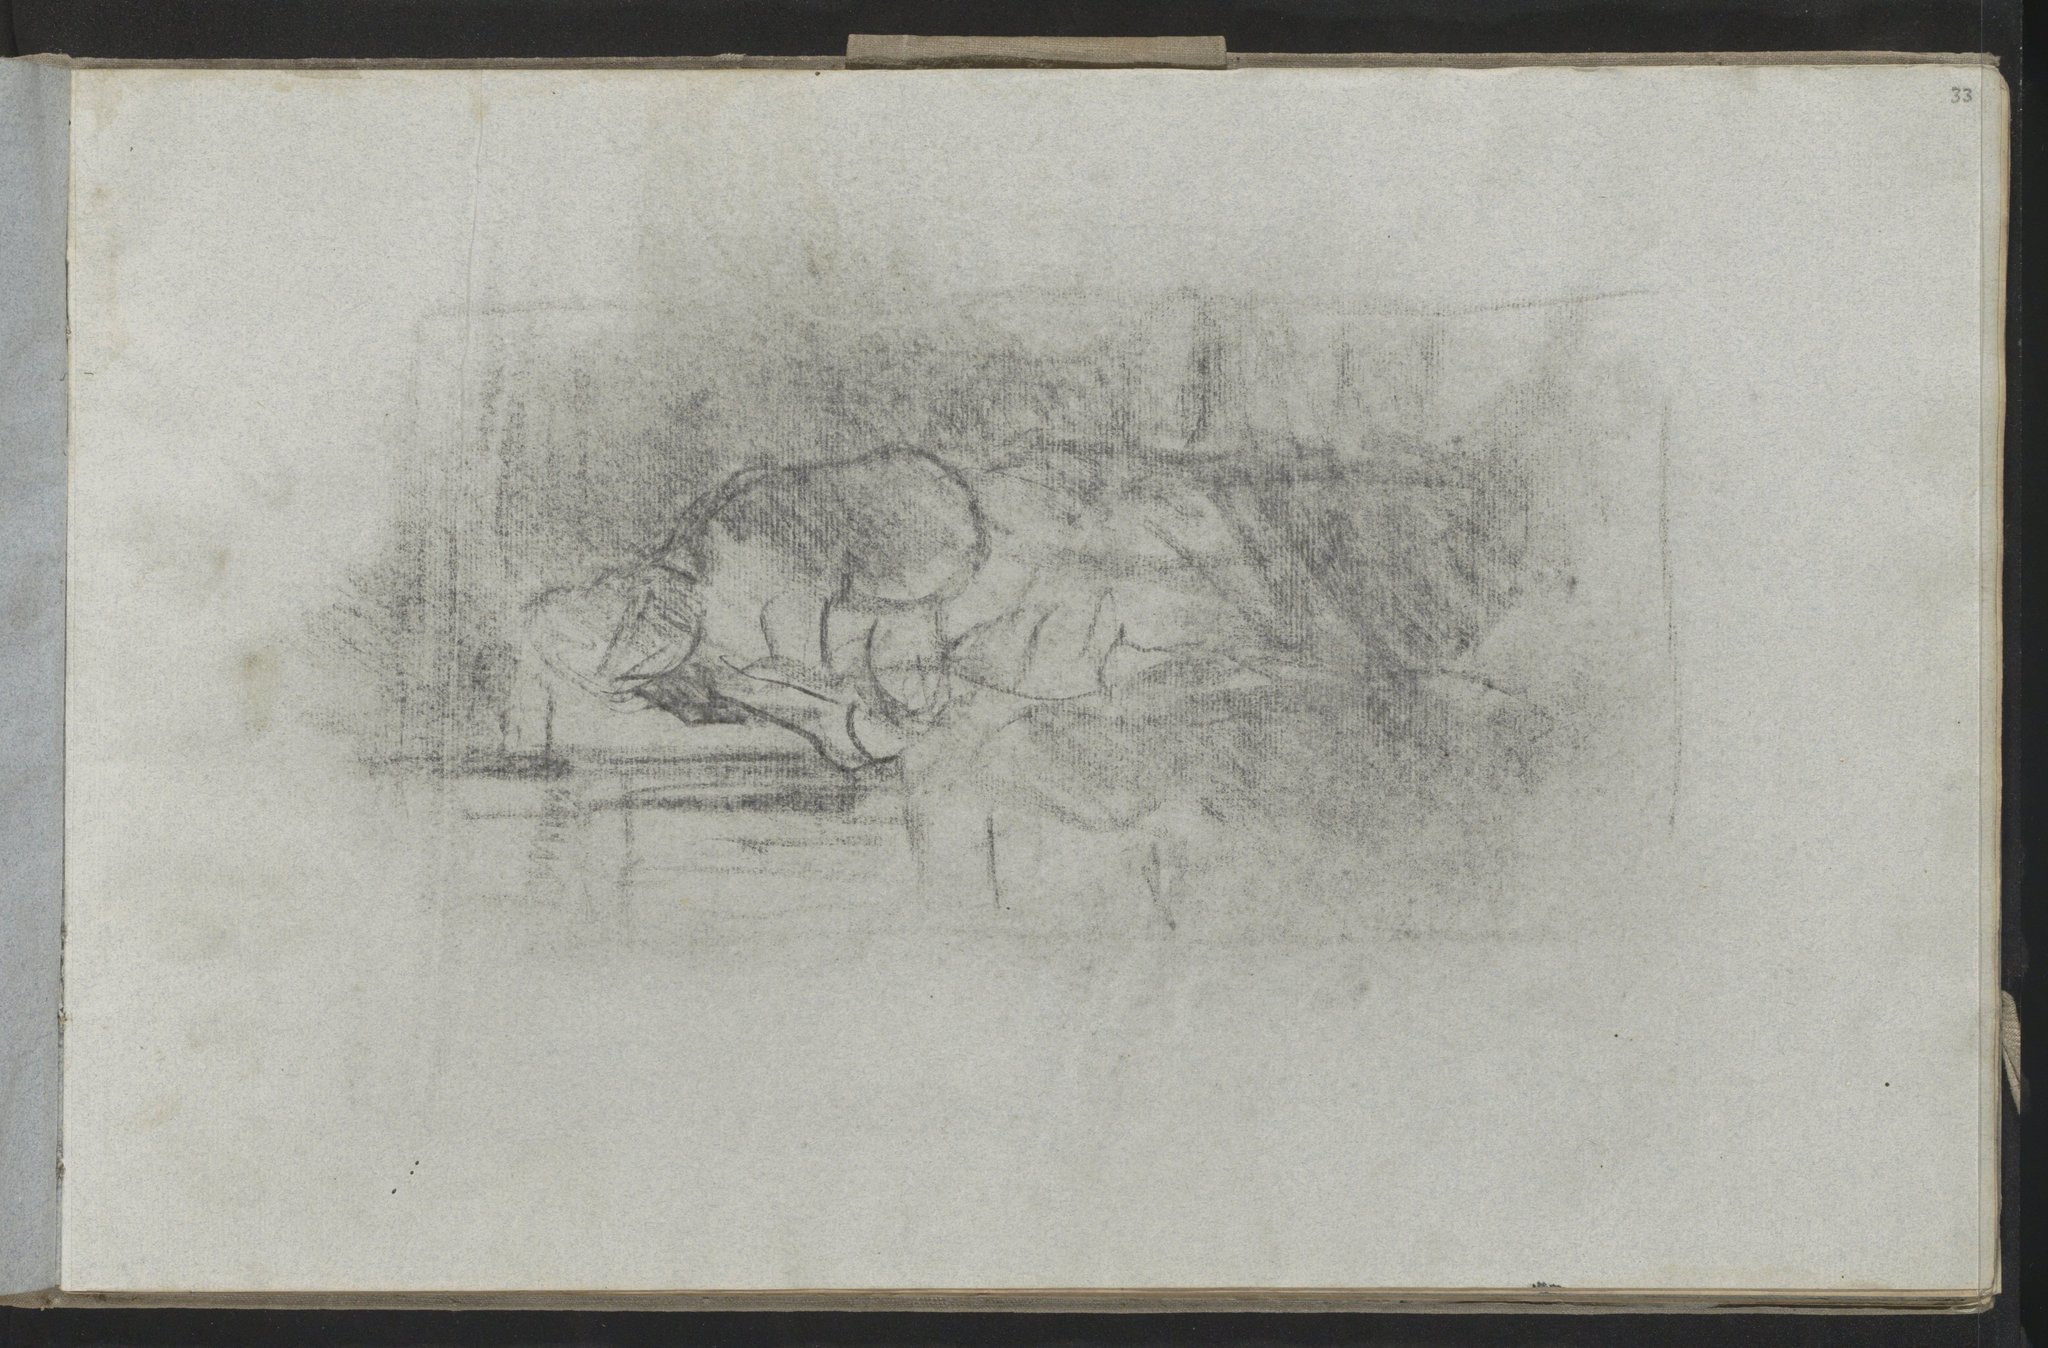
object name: sketchbook leaf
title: Vrouw bij een raamkozijn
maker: albert neuhuys (1844-1914)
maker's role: draughtsman, painter, print maker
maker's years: 1844-1914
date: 1854-1914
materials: charcoal, paper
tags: adult woman, window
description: Blad 33 recto uit een schetsboek met 51 bladen.